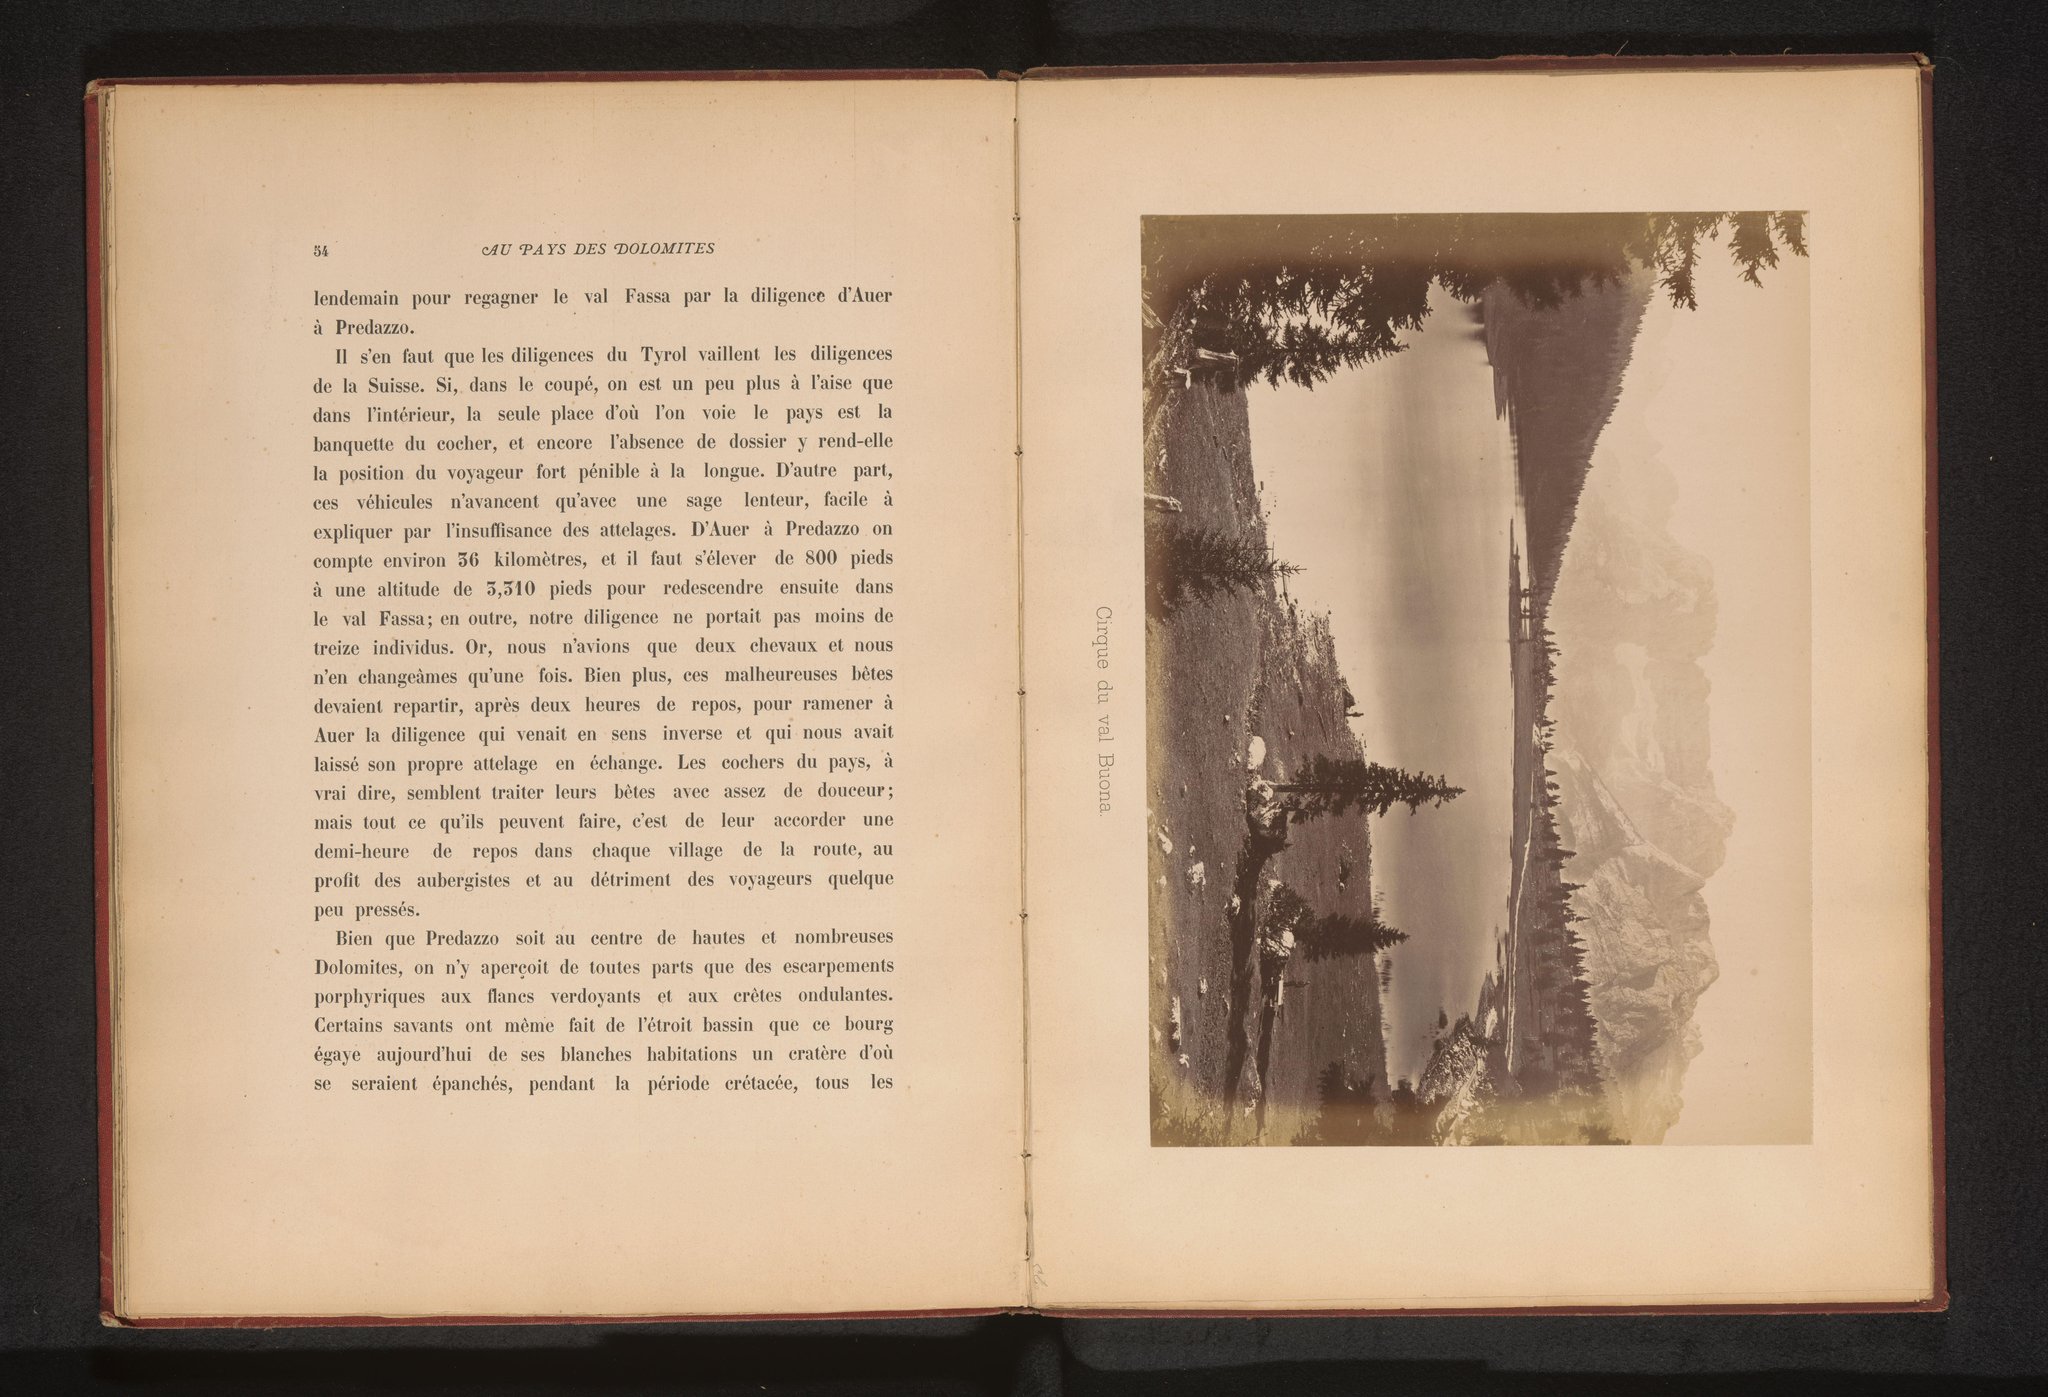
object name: photograph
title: Gezicht op een meer in de Dolomieten, Italië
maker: eugène goblet dalviella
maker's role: politician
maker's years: 1846-1925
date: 1873-1878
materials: photographic support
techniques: albumen print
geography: dolomites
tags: dale, valley, lake, mountains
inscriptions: inscription: ‘[..]’